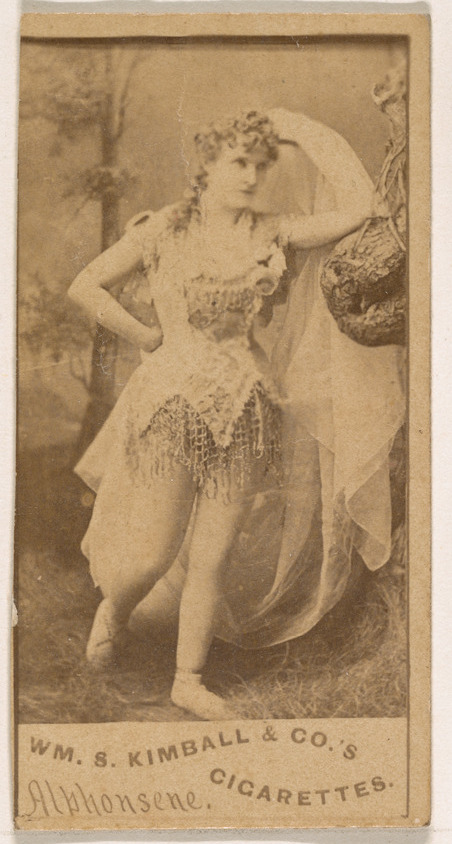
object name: photograph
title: Lady Alphonsene, from the Actresses series (N203) issued by Wm. S. Kimball & Co.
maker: william s. kimball & company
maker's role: publisher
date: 1889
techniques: color lithograph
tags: portraits,women,actresses